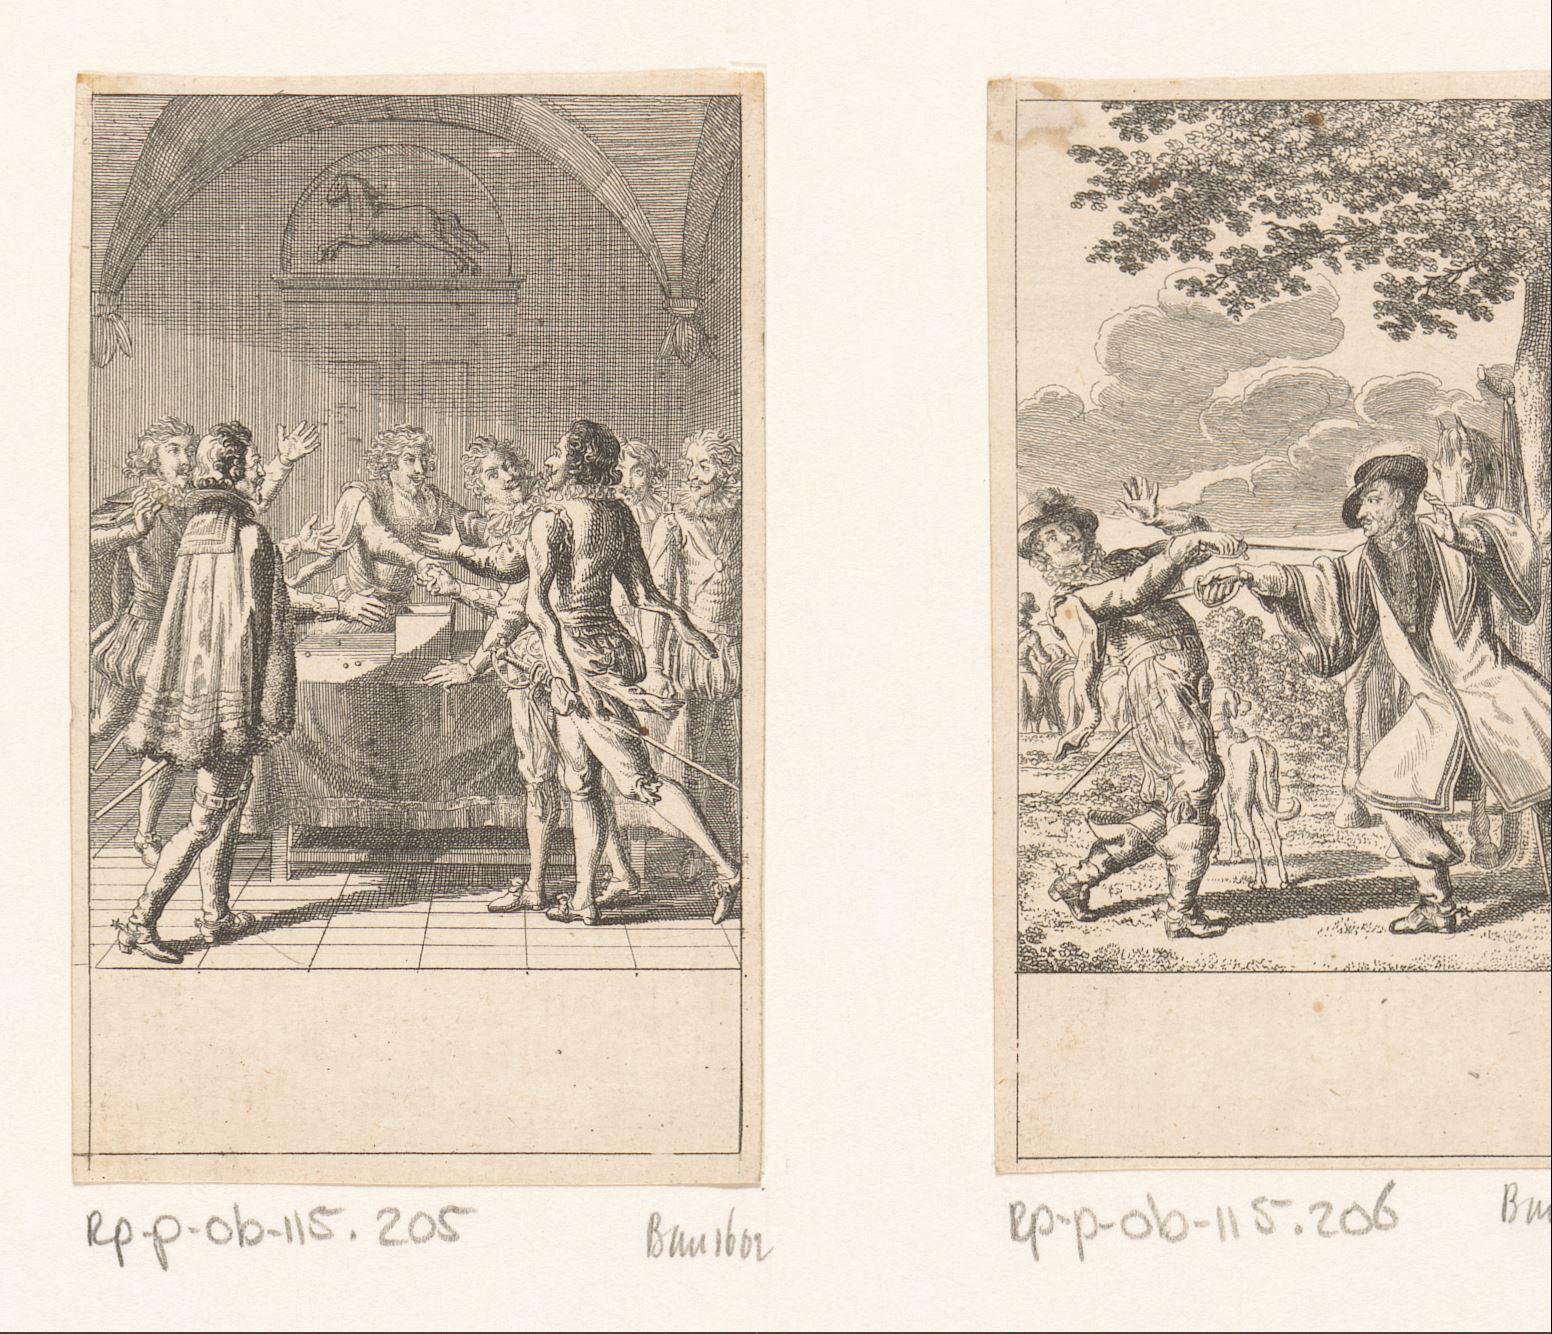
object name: print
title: Samenkomst van de zoons van Willem van Brunswijk-Lüneburg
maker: daniel nikolaus chodowiecki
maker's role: draughtsman, print maker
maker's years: 1726-1801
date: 1792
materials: paper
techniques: etching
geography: berlin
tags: history, debate, discussion (~ meeting), brothers (second degree family relationships)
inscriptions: collector's mark: Lugt 2228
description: Latere staat gebruikt voor: Almanac de Gotha pour l'anneé 1793. Gotha: C. W. Ettinger, [1792].